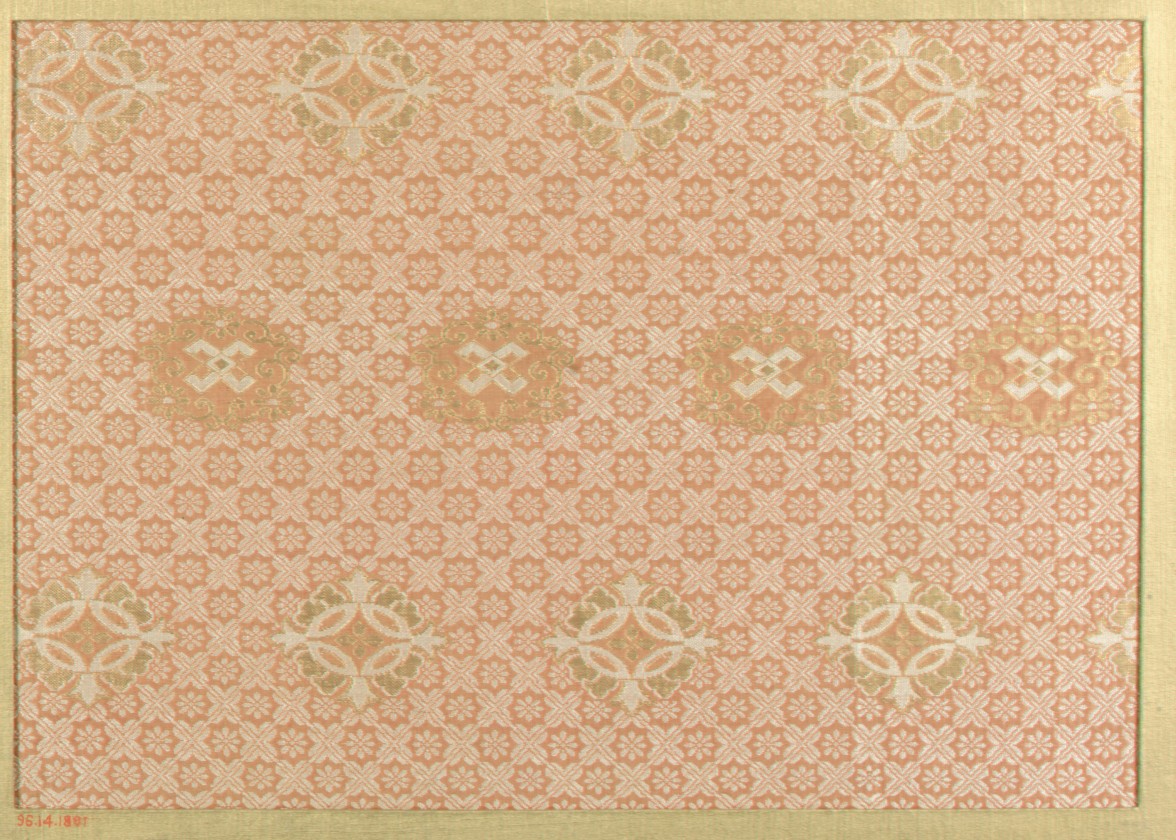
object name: piece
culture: japanese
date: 1701-1900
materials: silk